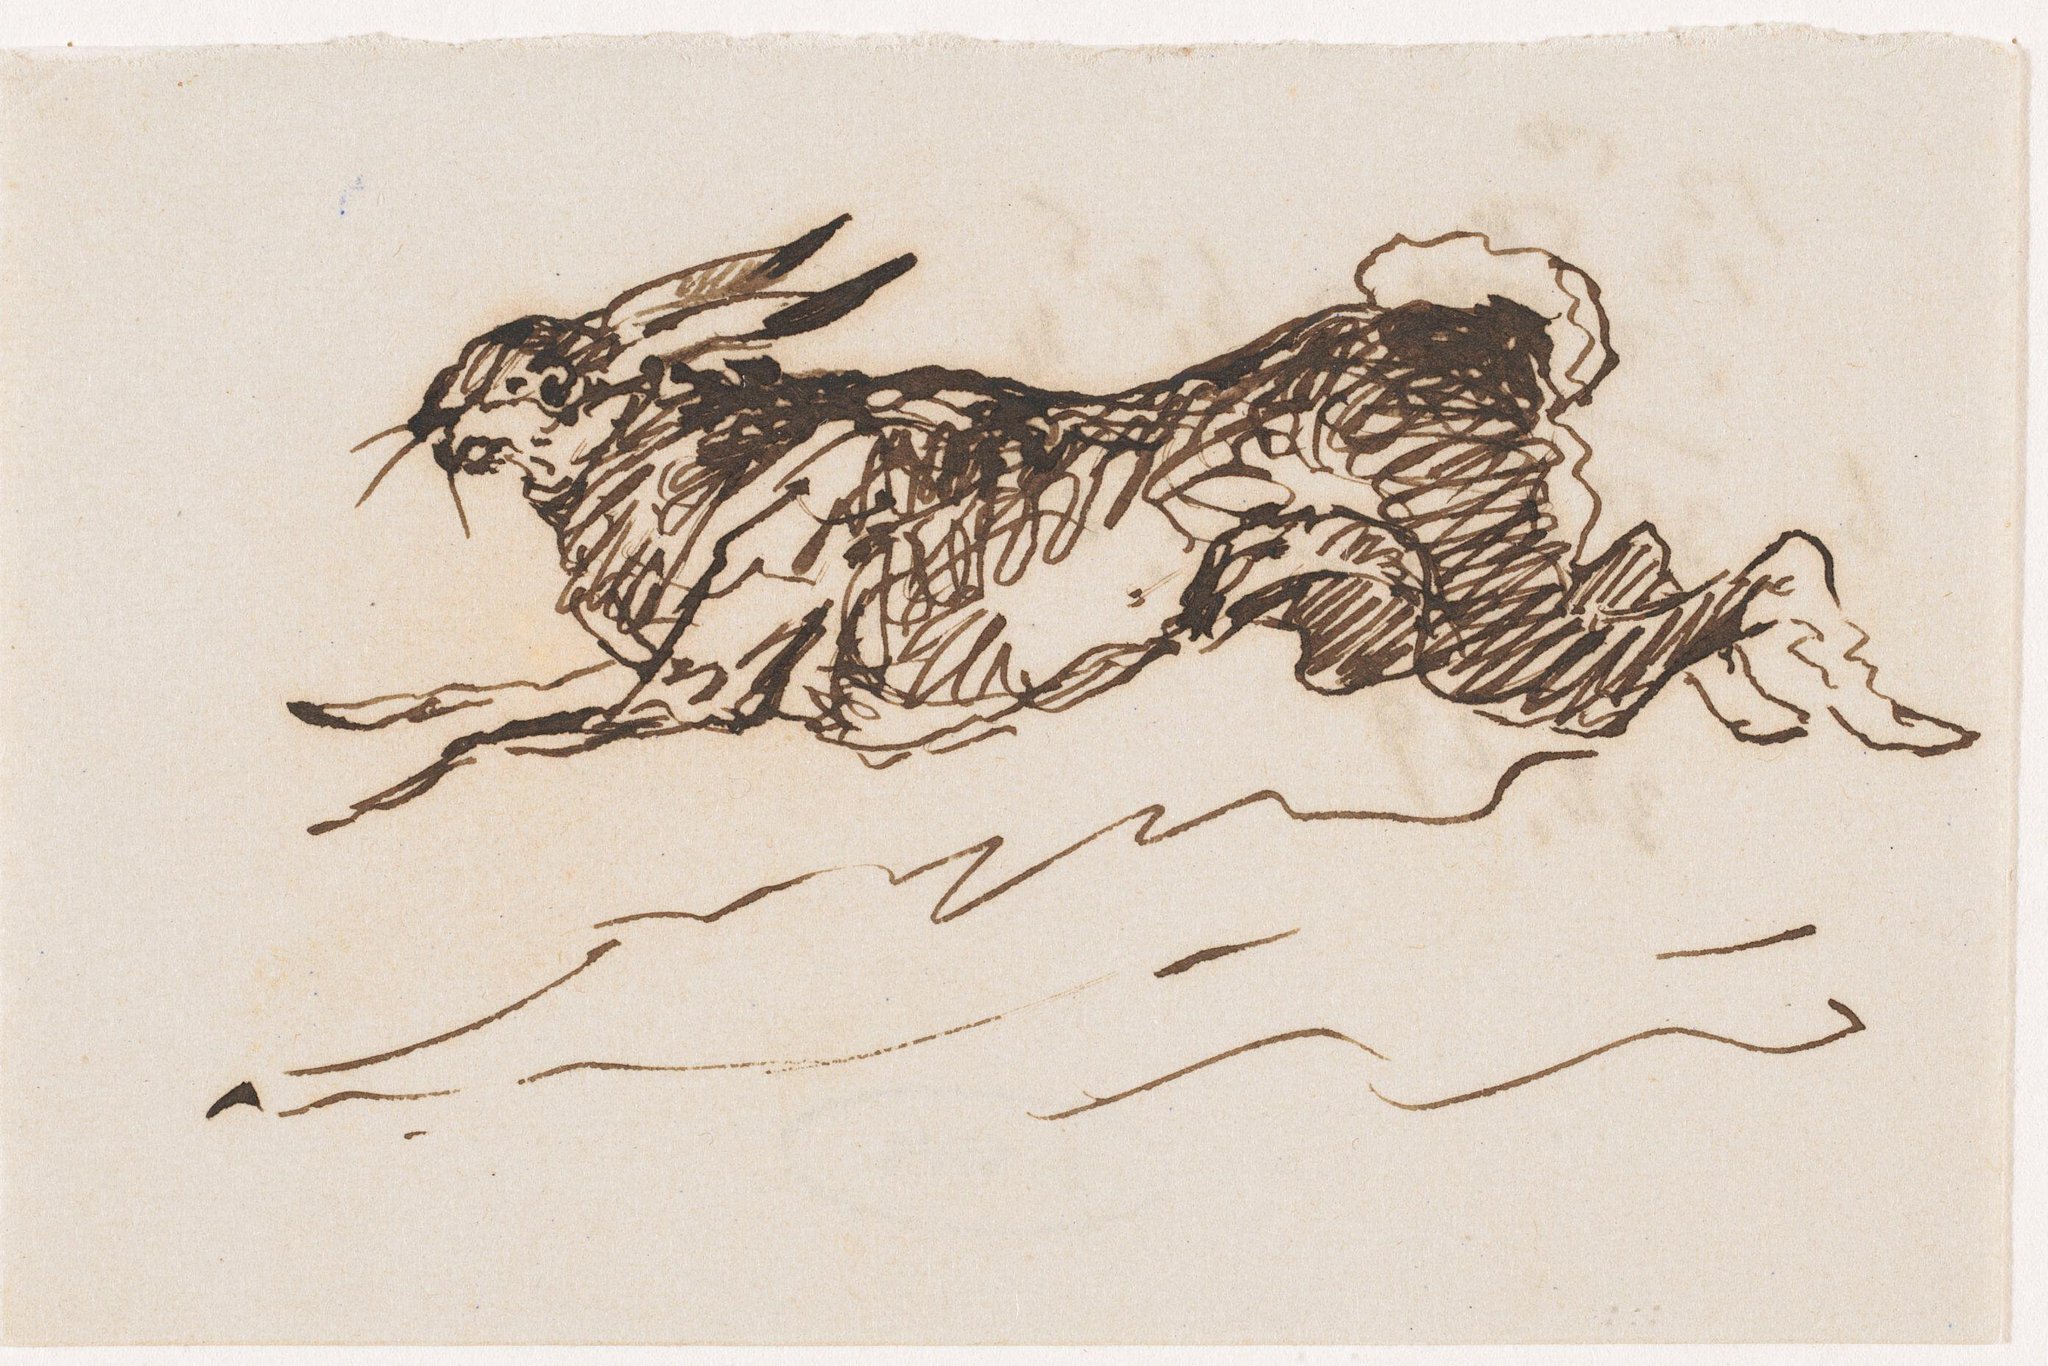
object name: drawing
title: Haas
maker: johannes tavenraat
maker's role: draughtsman, painter, print maker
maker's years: 1809-1881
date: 1840-1880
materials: ink, paper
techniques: pen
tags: rodents: hare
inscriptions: collector's mark: Lugt 2228